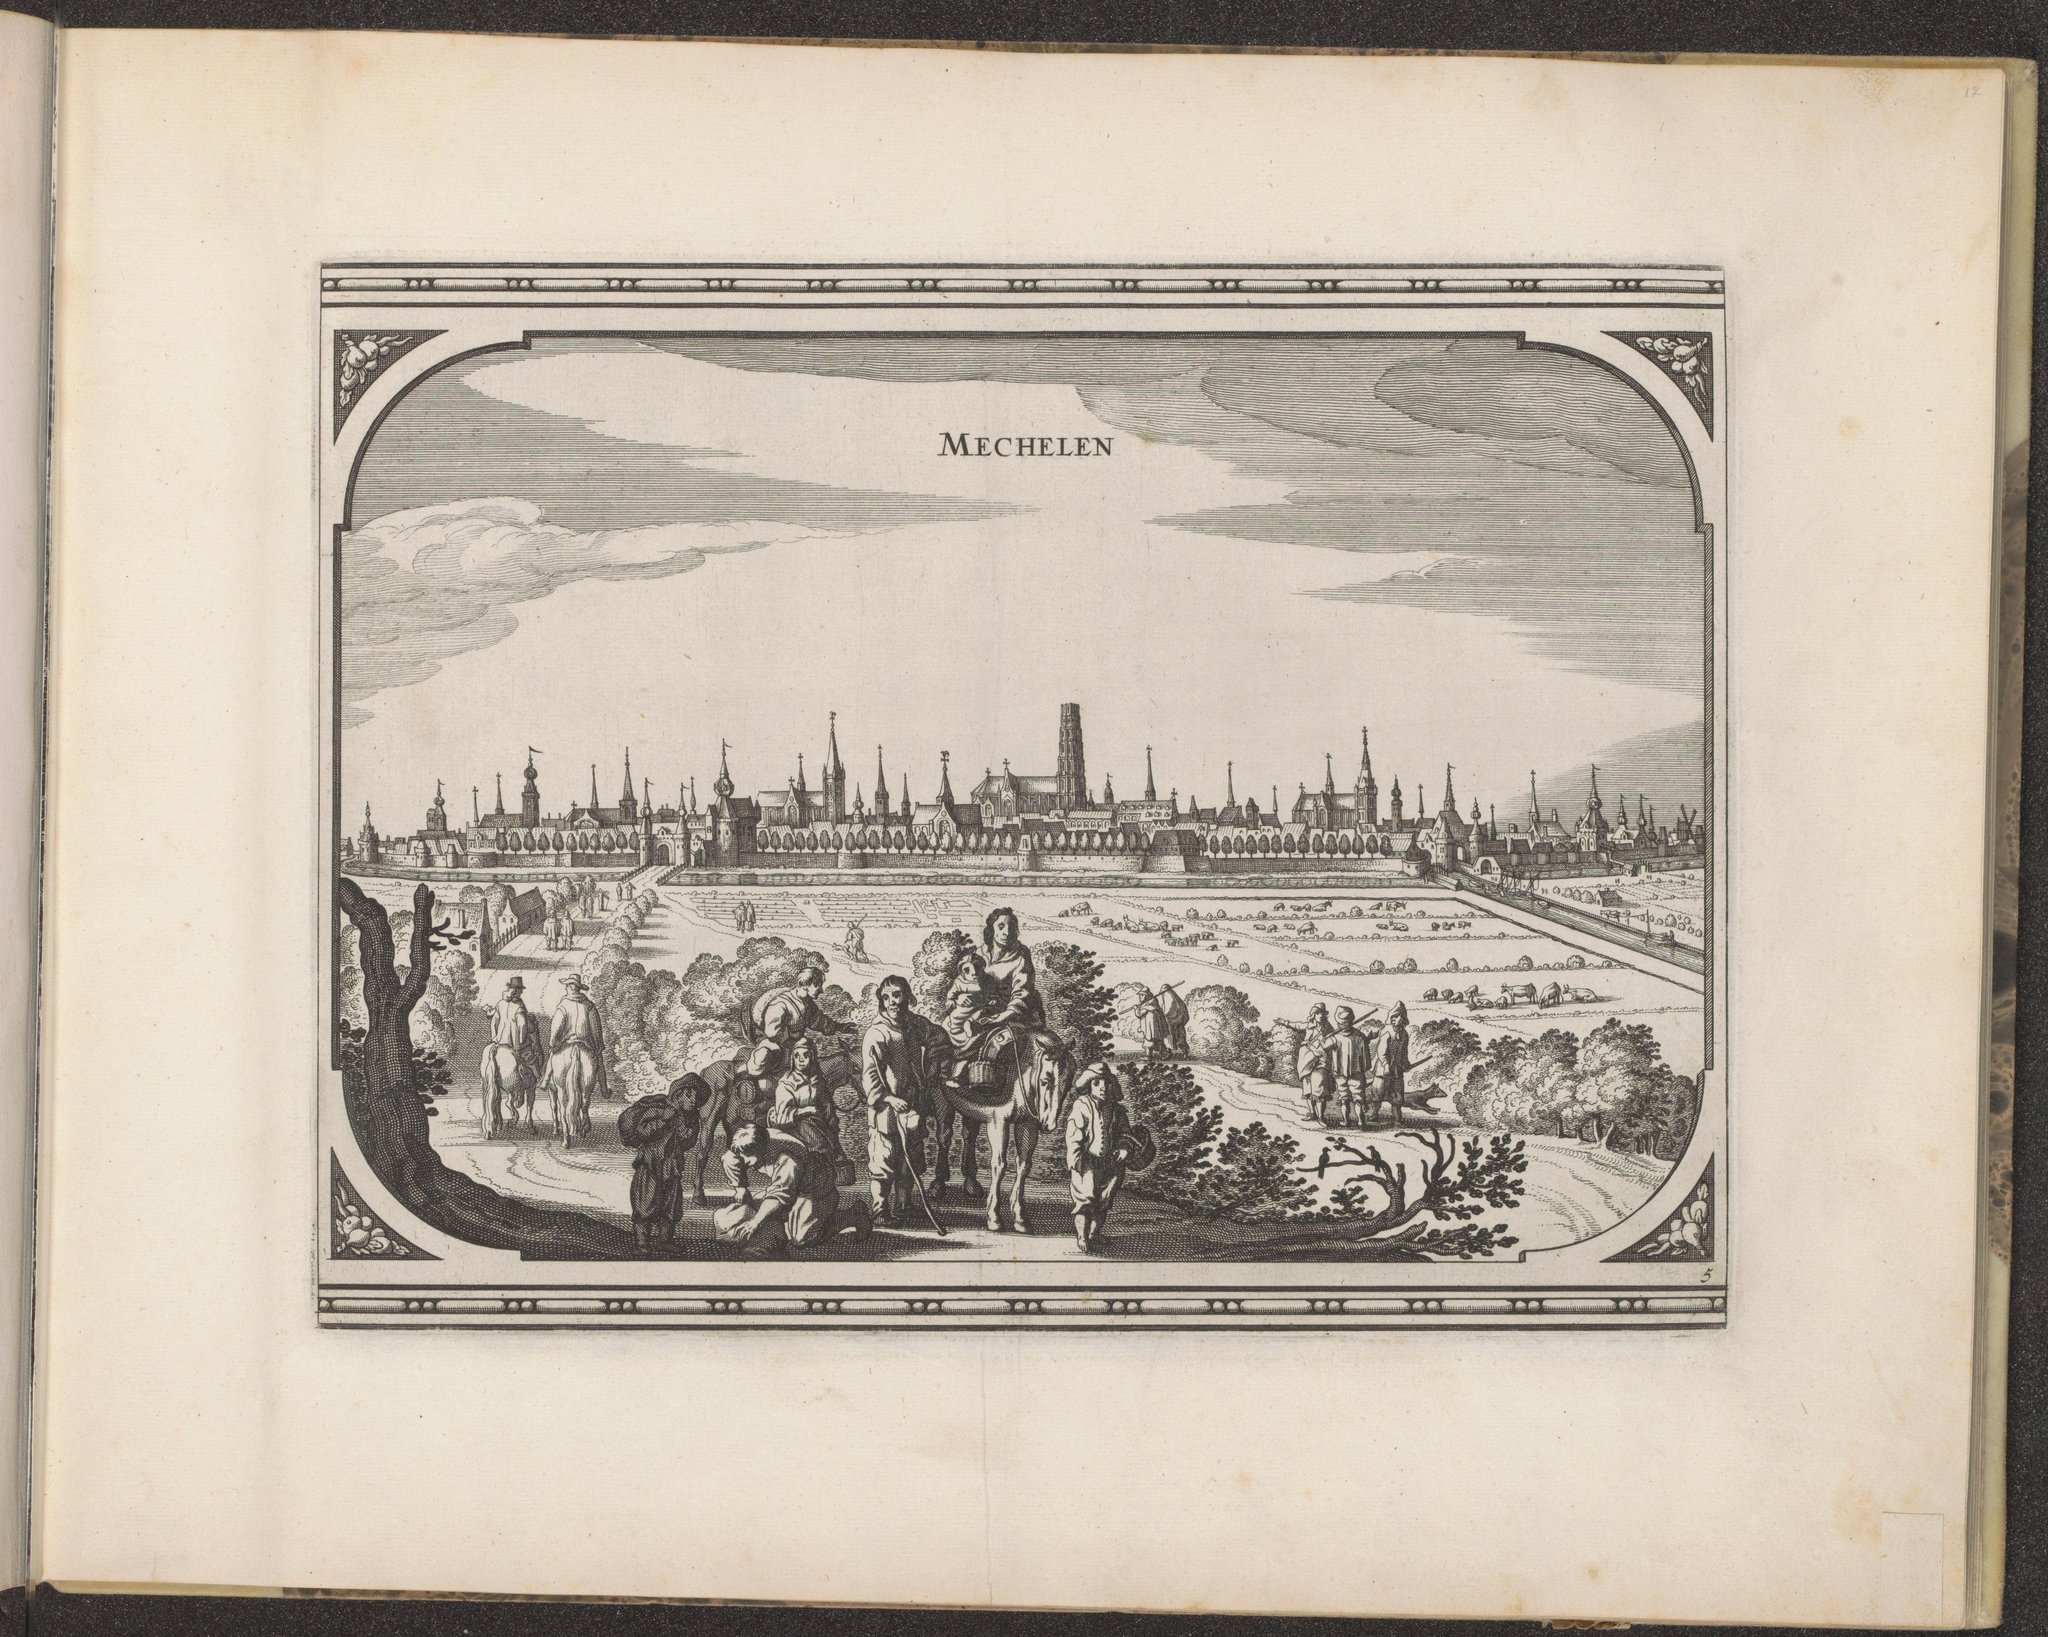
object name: print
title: Gezicht op Mechelen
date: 1660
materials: paper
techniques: etching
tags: riding a horse, ass, or mule; rider, horseman, city-view, and landscape with man-made constructions, 'en route', traveller under way, mechelen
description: Gezicht op de stad Mechelen. Twee wegen leiden naar de stad. Op de voorgrond onder meer een vrouw met kind op een paard. Haar man staat ernaast. Ze wachten op een jongen die op zijn knieën zijn spullen inpakt. De prent maakt deel uit van een album.